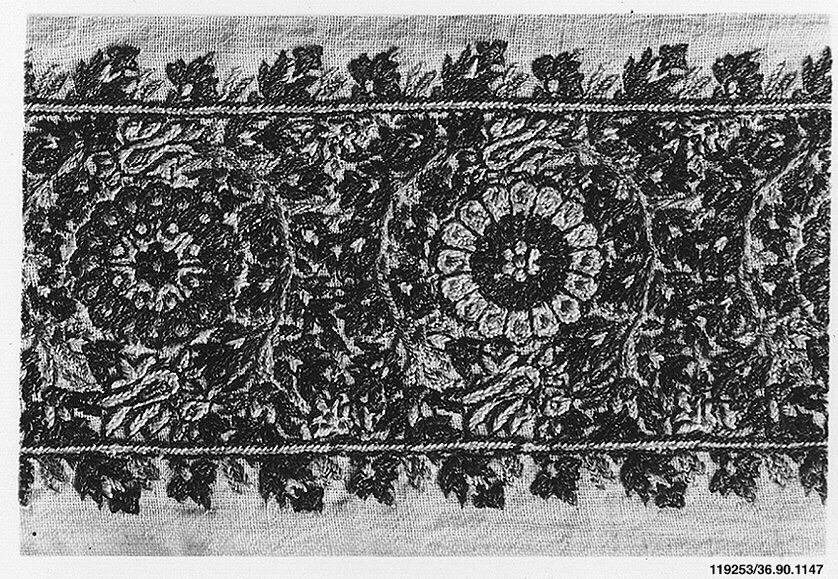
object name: piece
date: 1801-1900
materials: cotton, silk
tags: flowers